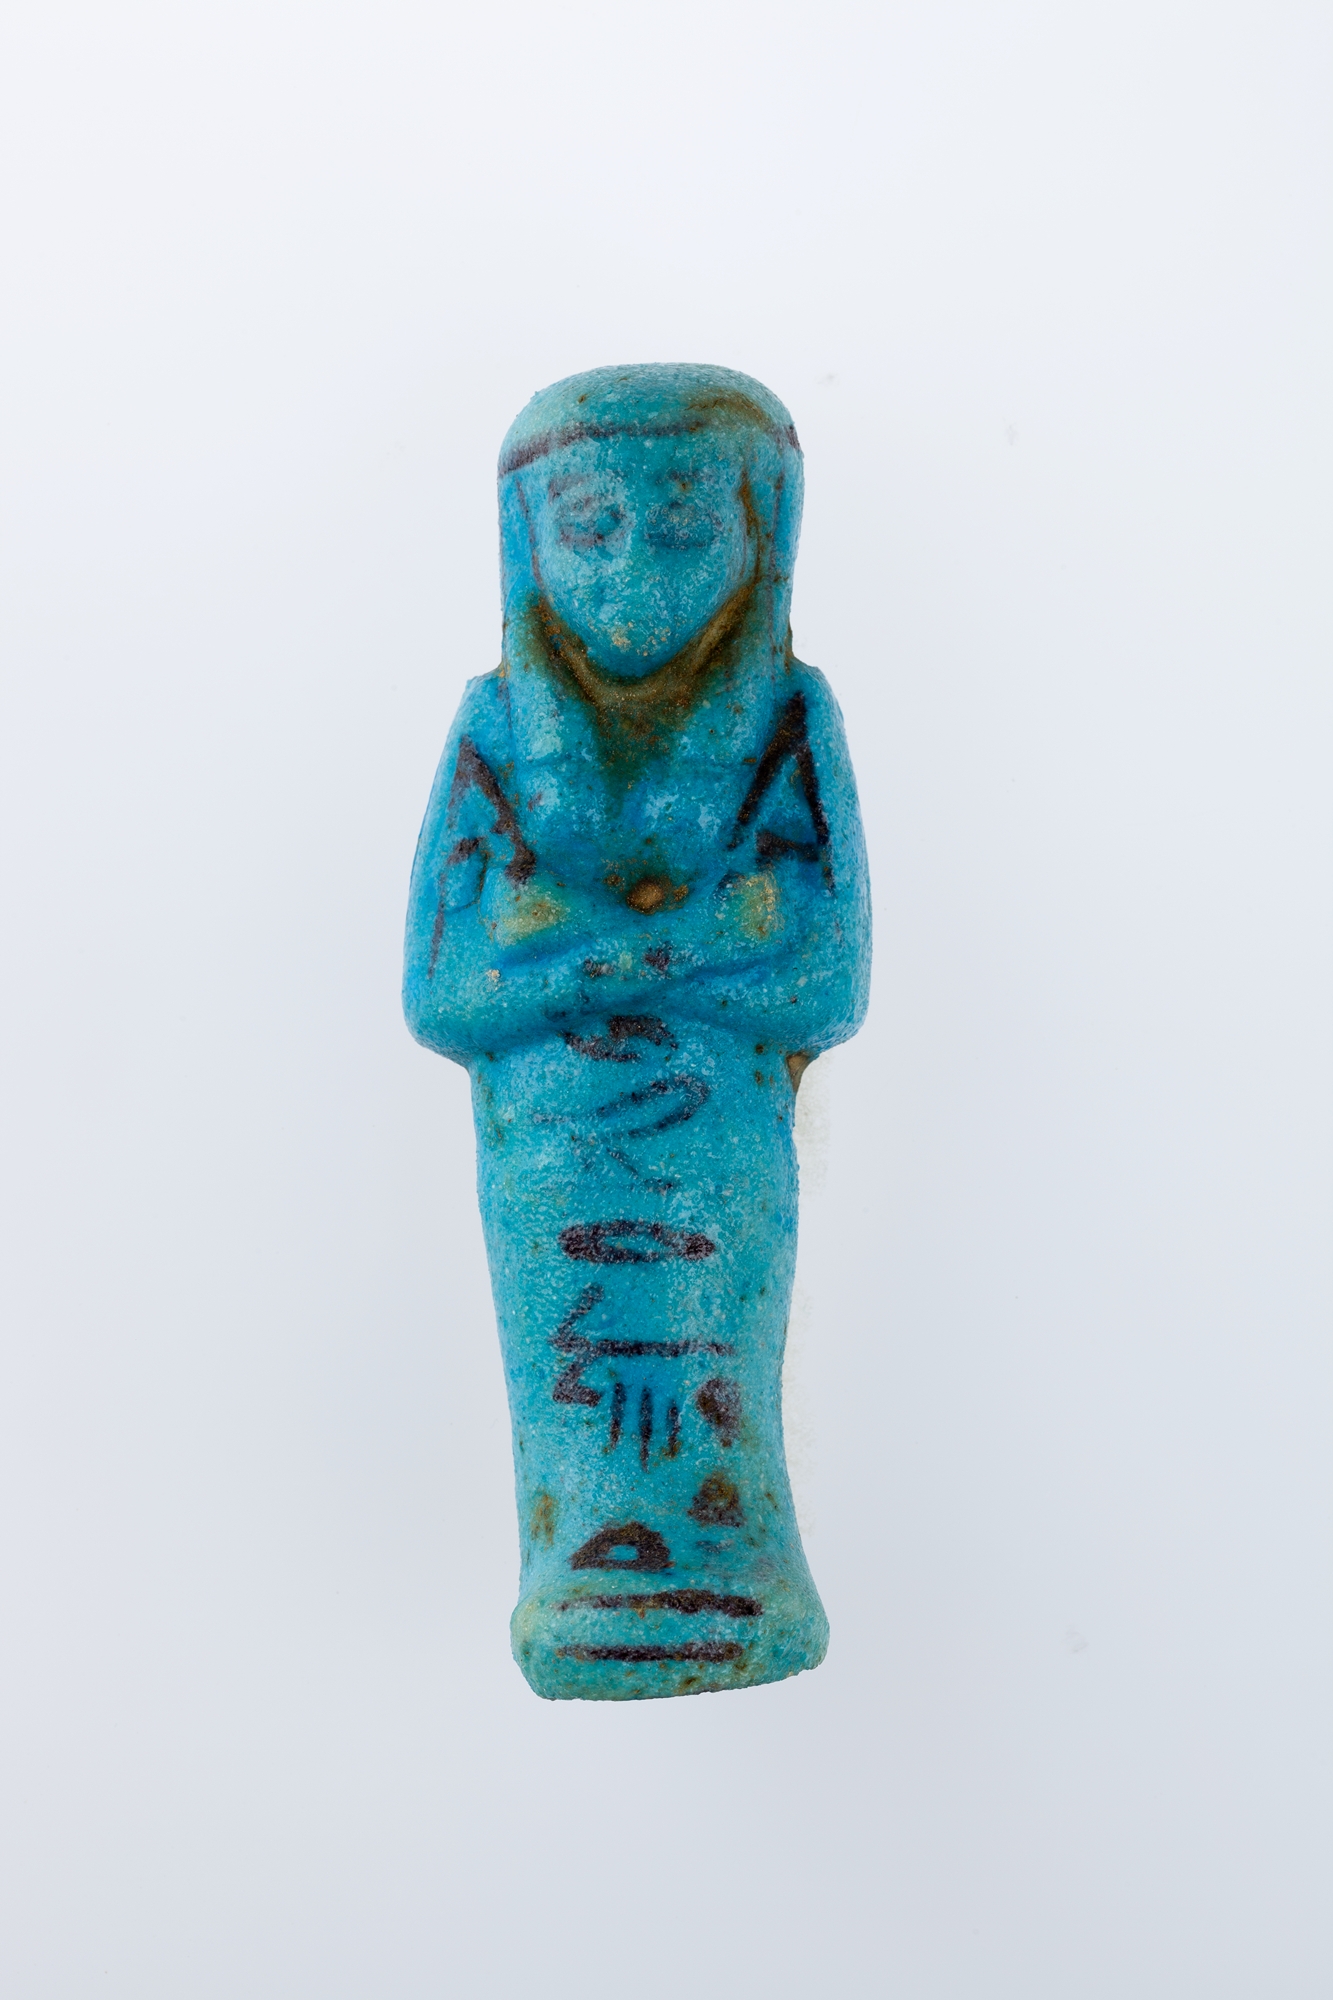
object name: shabti, henettawy c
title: Worker Shabti of Henettawy (C), Daughter of Isetemkheb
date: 990-970 BCE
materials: faience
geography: egypt